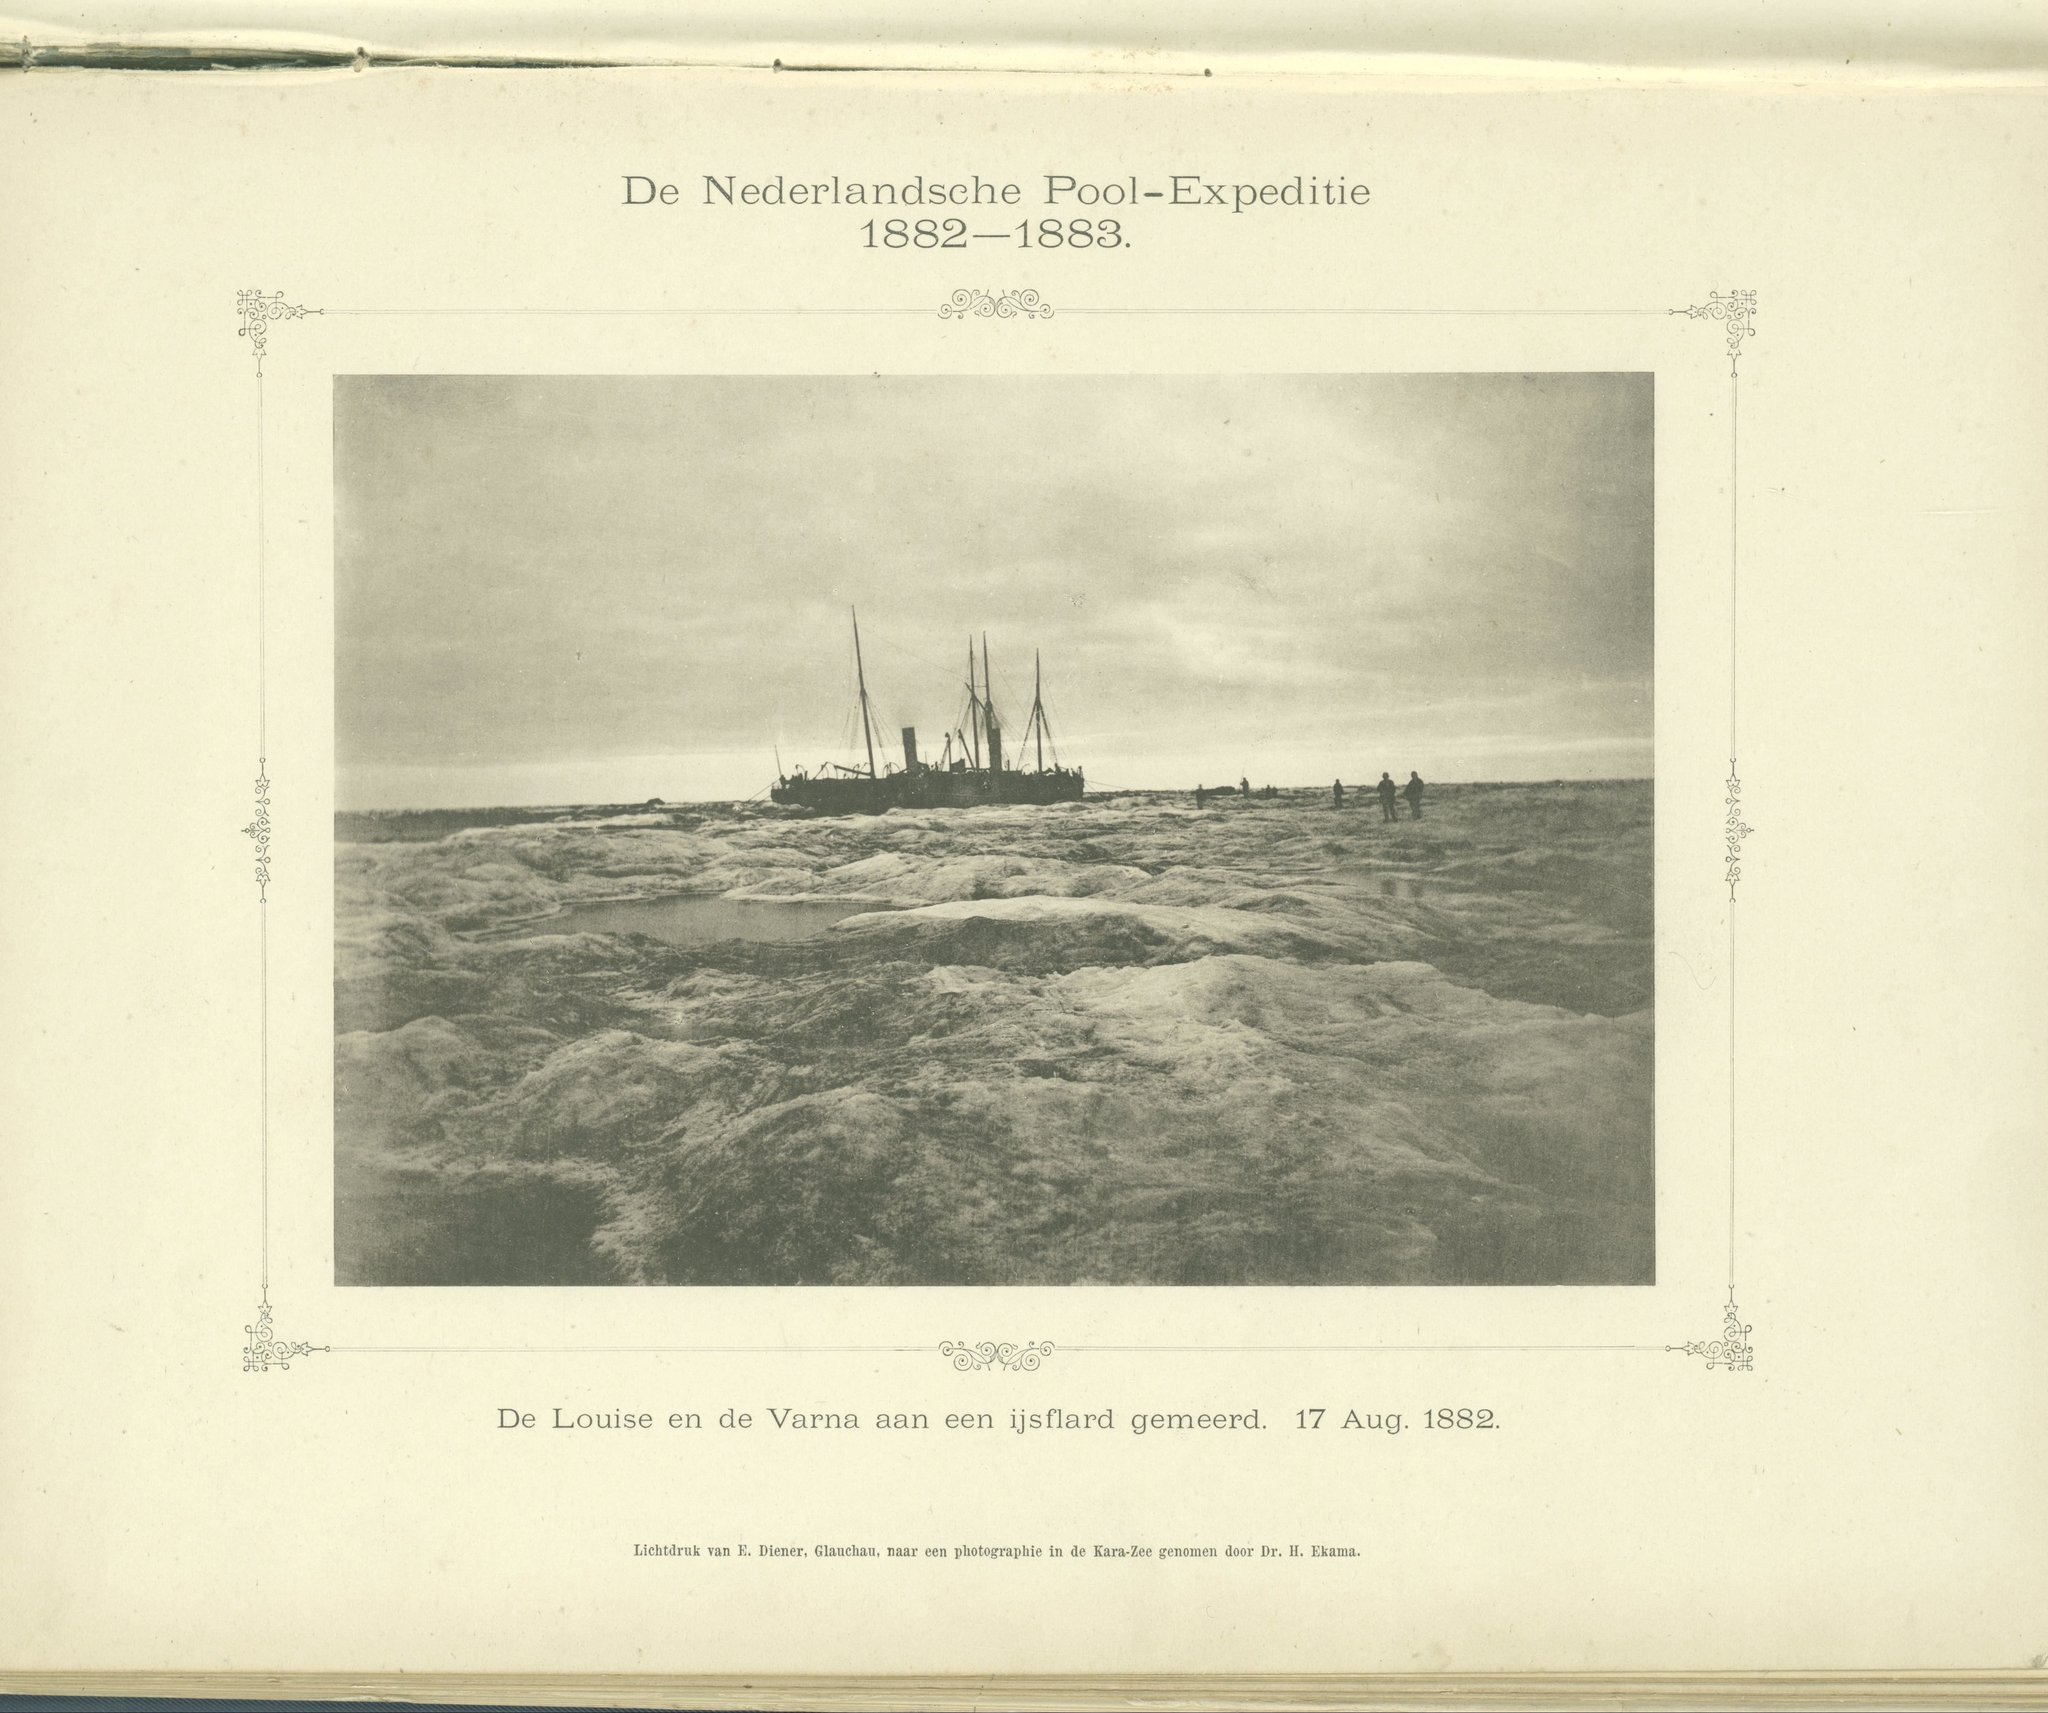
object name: photograph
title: De Louise en de Varna aan een ijsflard gemeerd. 17 Aug. 1882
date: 1886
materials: paper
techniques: photograph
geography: london